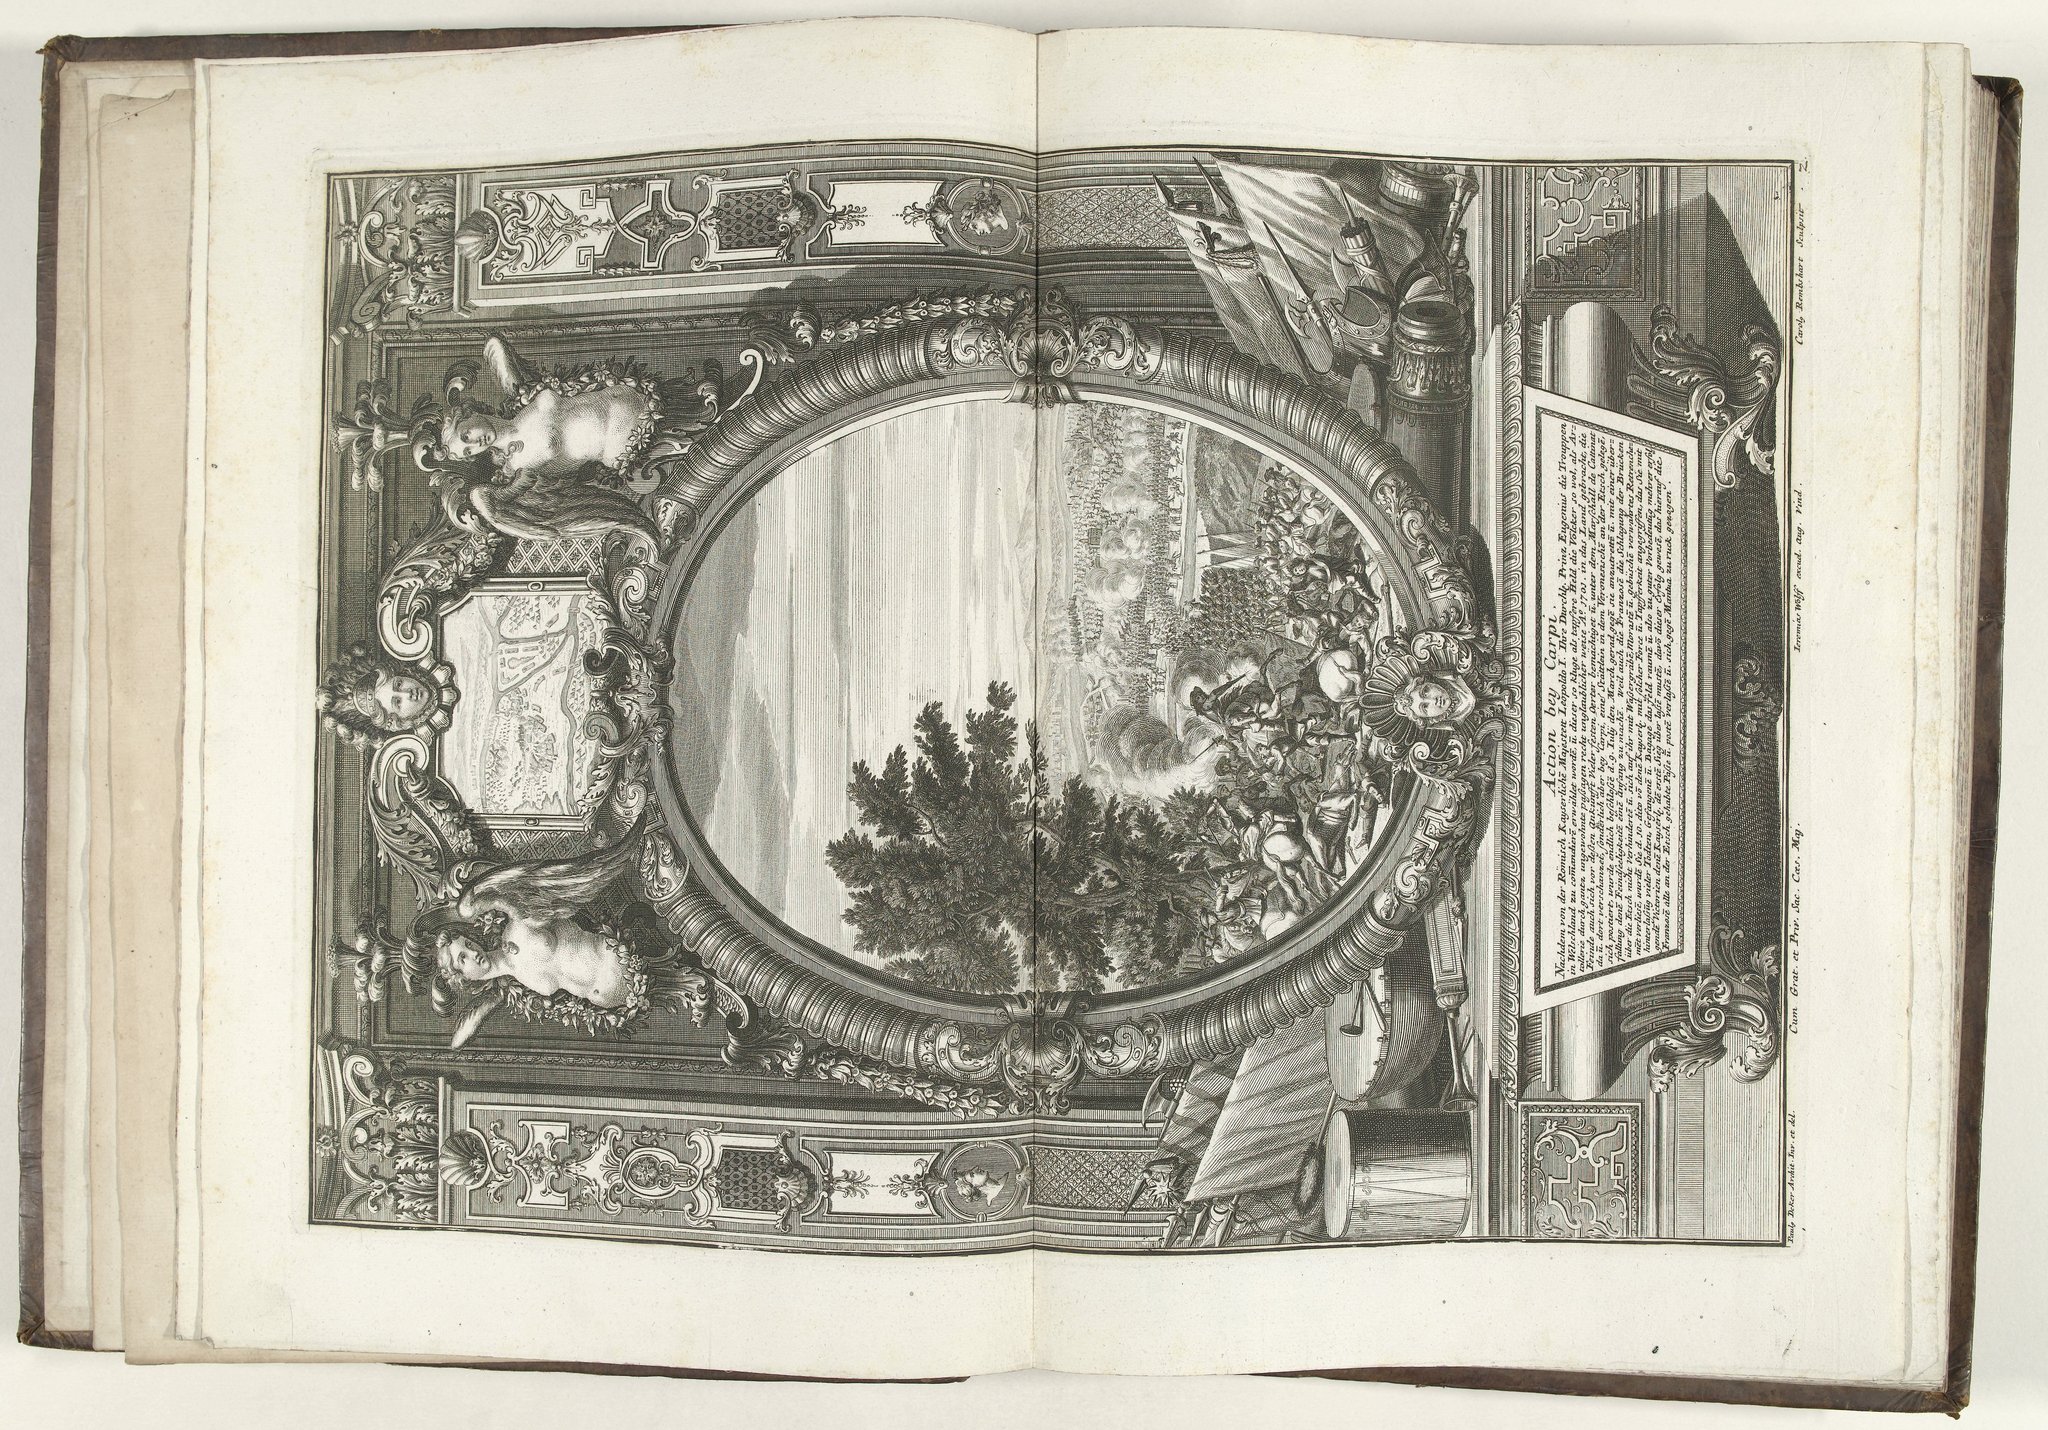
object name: history print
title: Inname van Carpi in Italië, 1701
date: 1712-1715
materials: paper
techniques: engraving, etching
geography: augsburg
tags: battle (+ land forces)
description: Inname van Carpi in Italië door het keizerlijke leger onder Eugenius van Savoye, 10 juni 1701. Ovale voorstelling van het gevecht in een rijke ornamentele omlijsting met wapens en vaandels. Onderaan een cartouche met een beschrijving van de gevechten in het Duits. Blad in de gebonden verzameling platen uitgebracht onder de titel: Repraesentatio belli ... Der Spanische Successions-Krieg [ca. 1720].